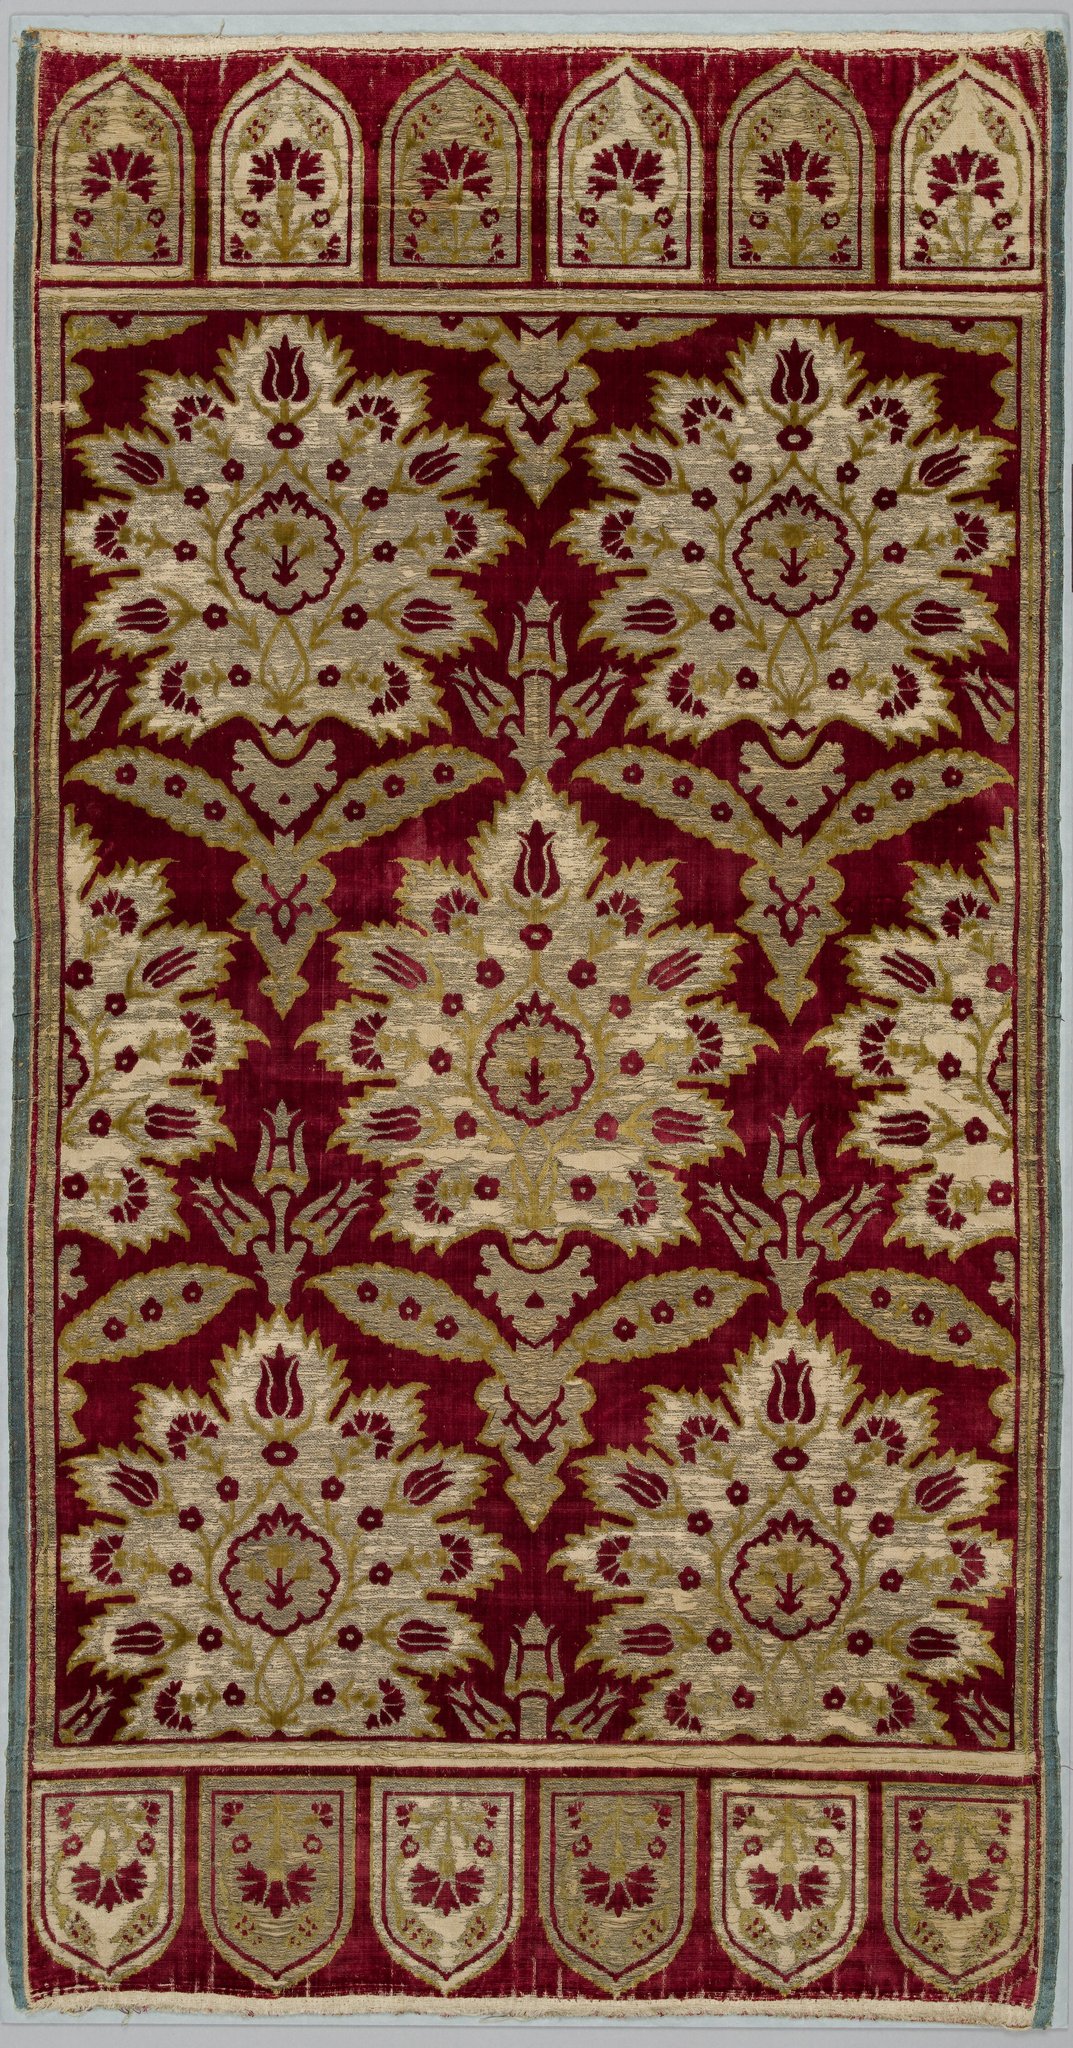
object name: cushion cover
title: Yastik Cushion Cover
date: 1600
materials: cotton, metal thread, silk, velvet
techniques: brocade, cutting, voiding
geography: turkey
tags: flowers